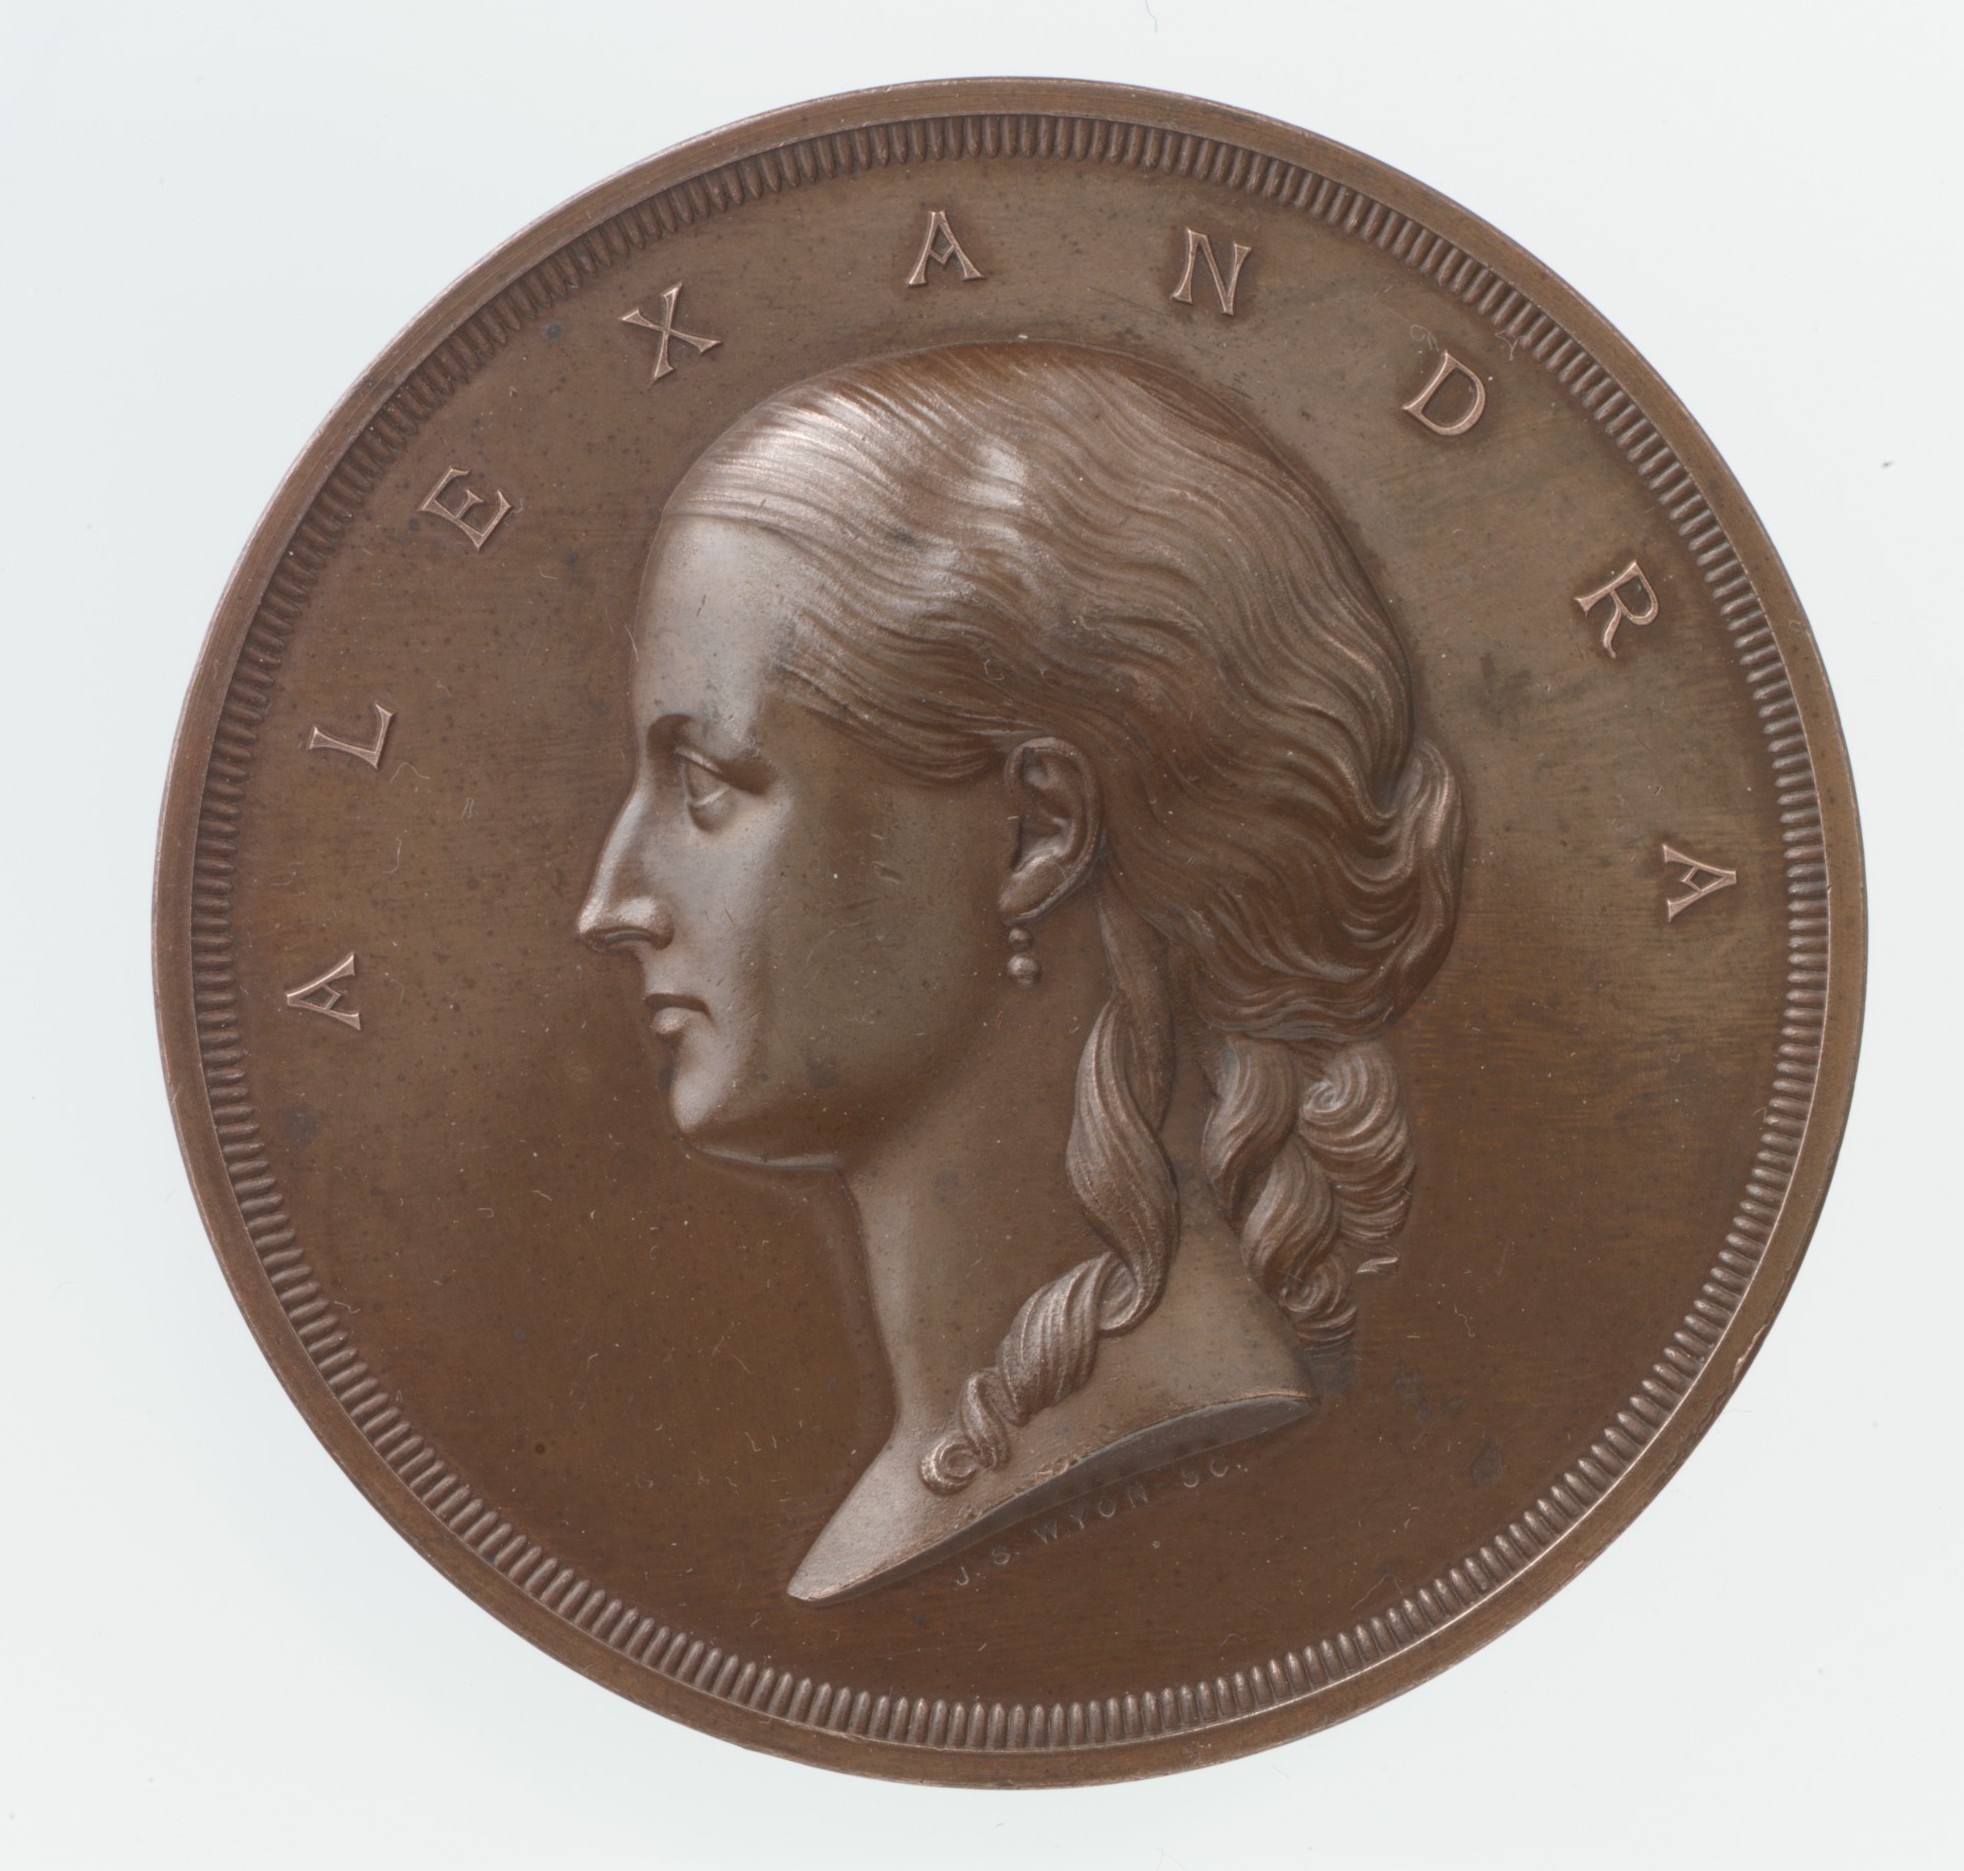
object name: medal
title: Princess Alexandra Welcomed to England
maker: joseph shepherd wyon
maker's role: artist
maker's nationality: british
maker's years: 1836-1873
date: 1863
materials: bronze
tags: princesses,men,profiles,women